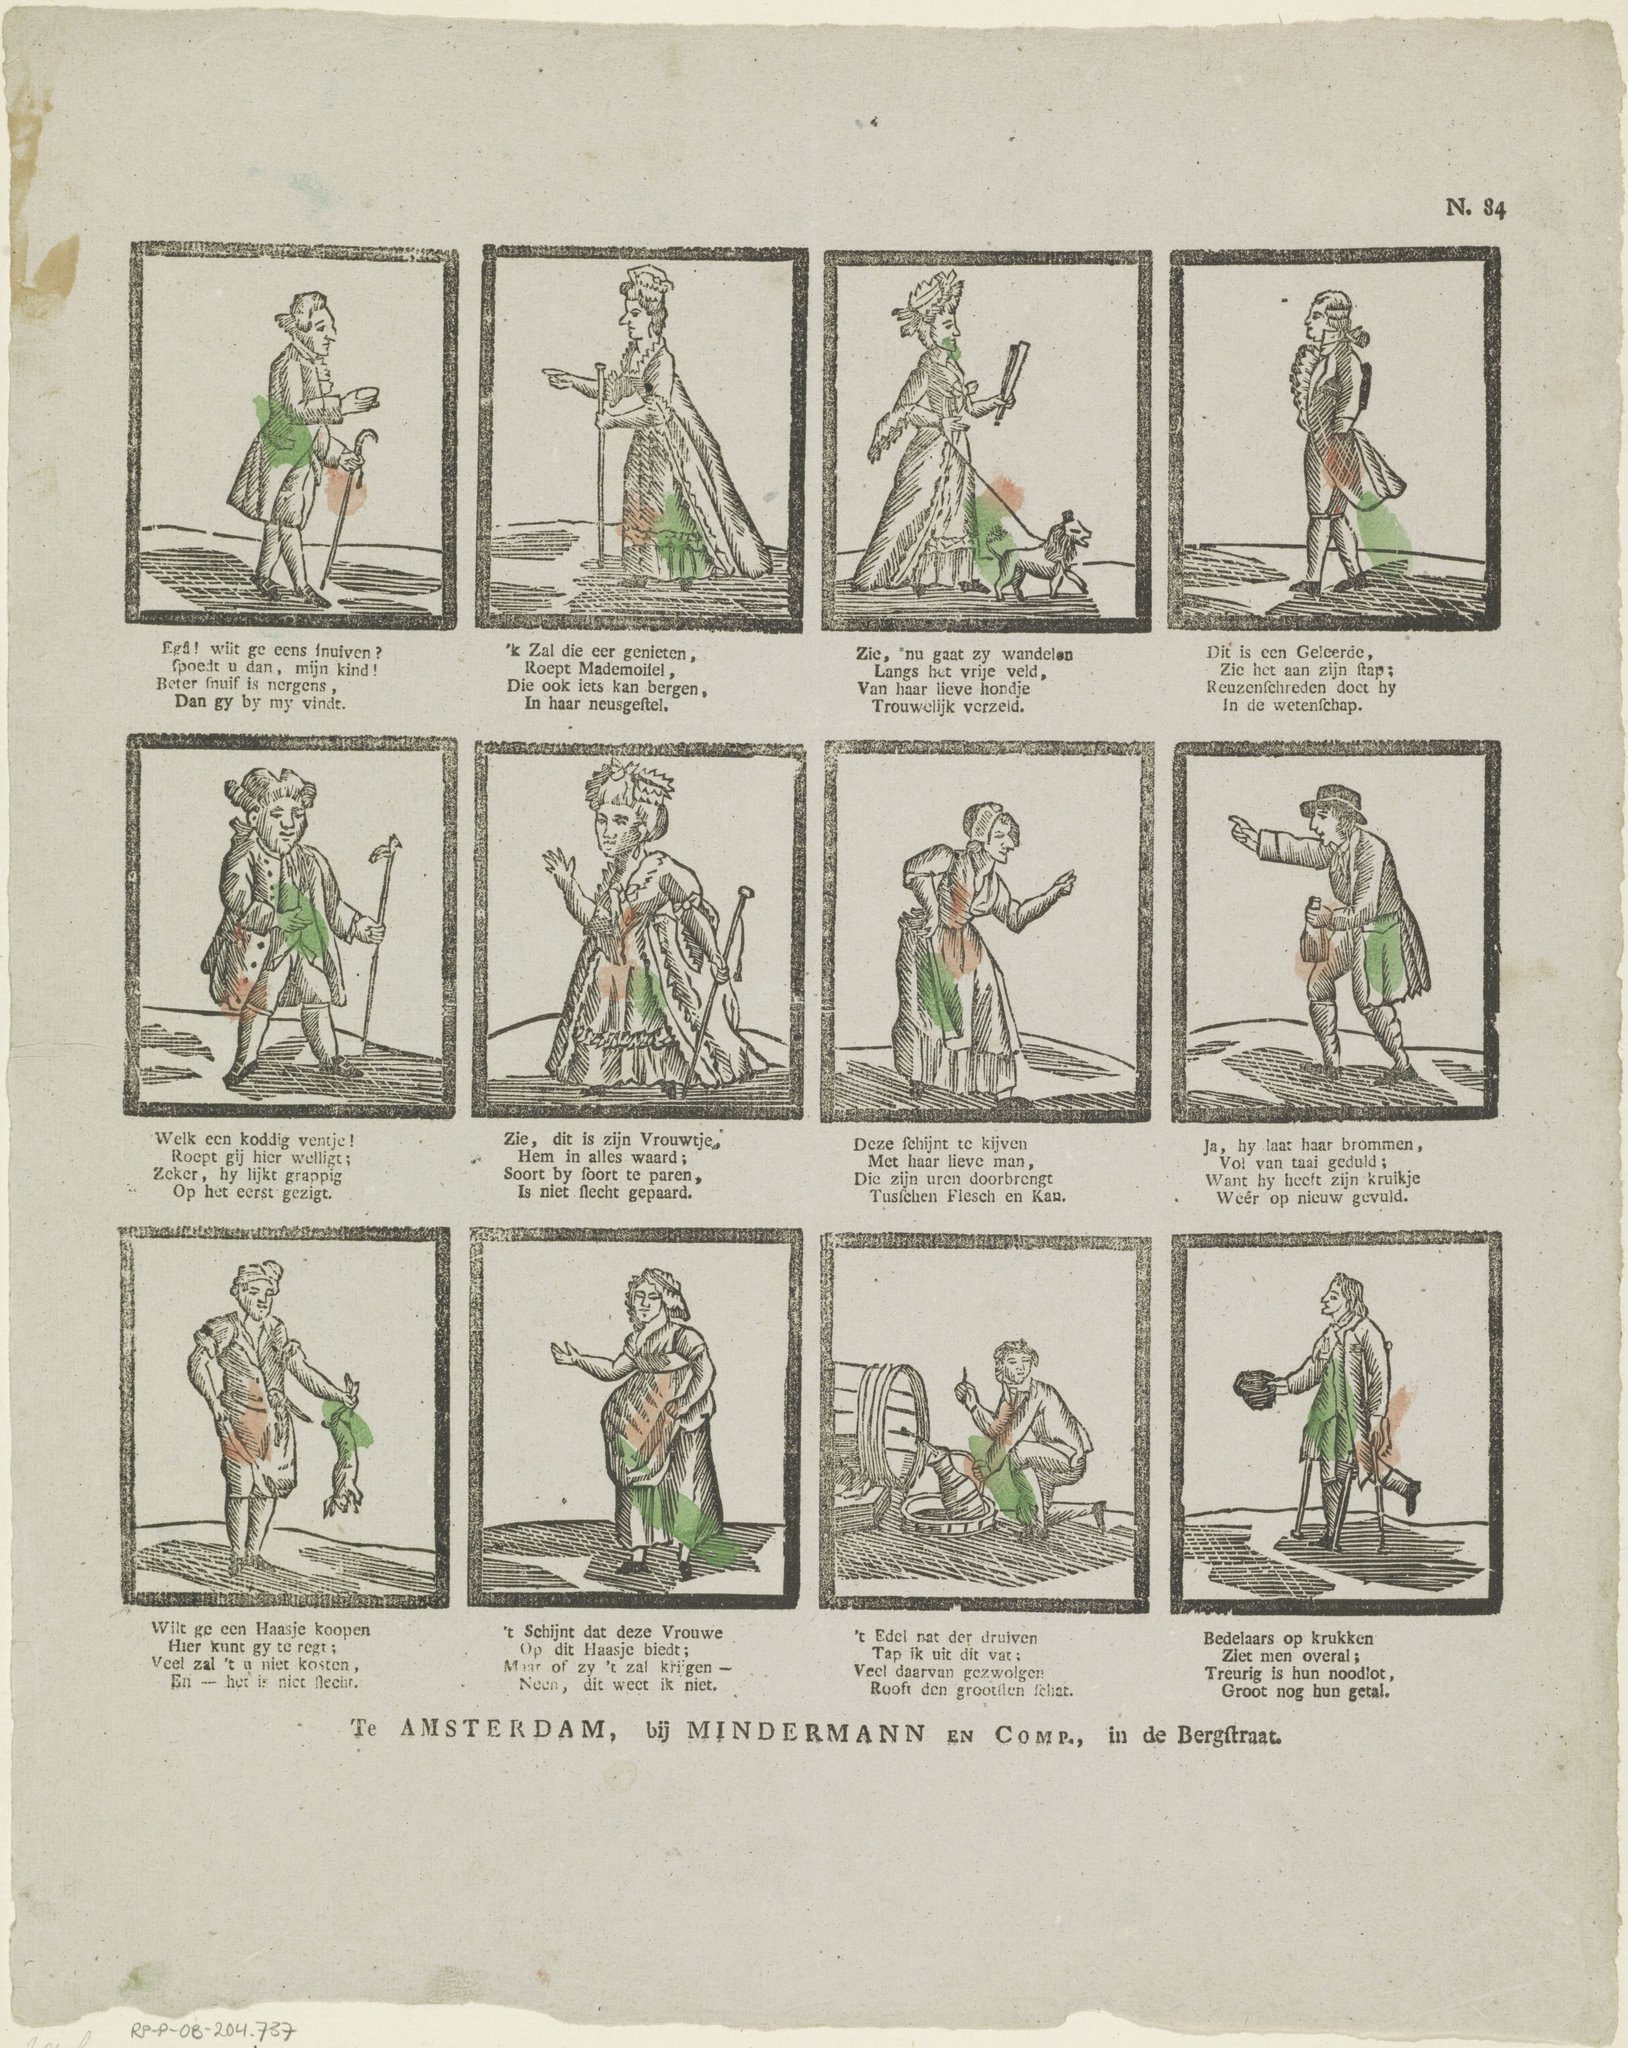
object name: popular print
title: Figuren en bezigheden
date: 1822-1849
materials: paper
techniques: colour, letterpress printing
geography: netherlands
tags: human types, caricatures (human types)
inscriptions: collector's mark: Lugt 2760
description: Blad met 12 voorstellingen van verschillende figuren en bezigheden. Onder elke afbeelding een vierregelig vers. Genummerd rechtsboven: N. 84.